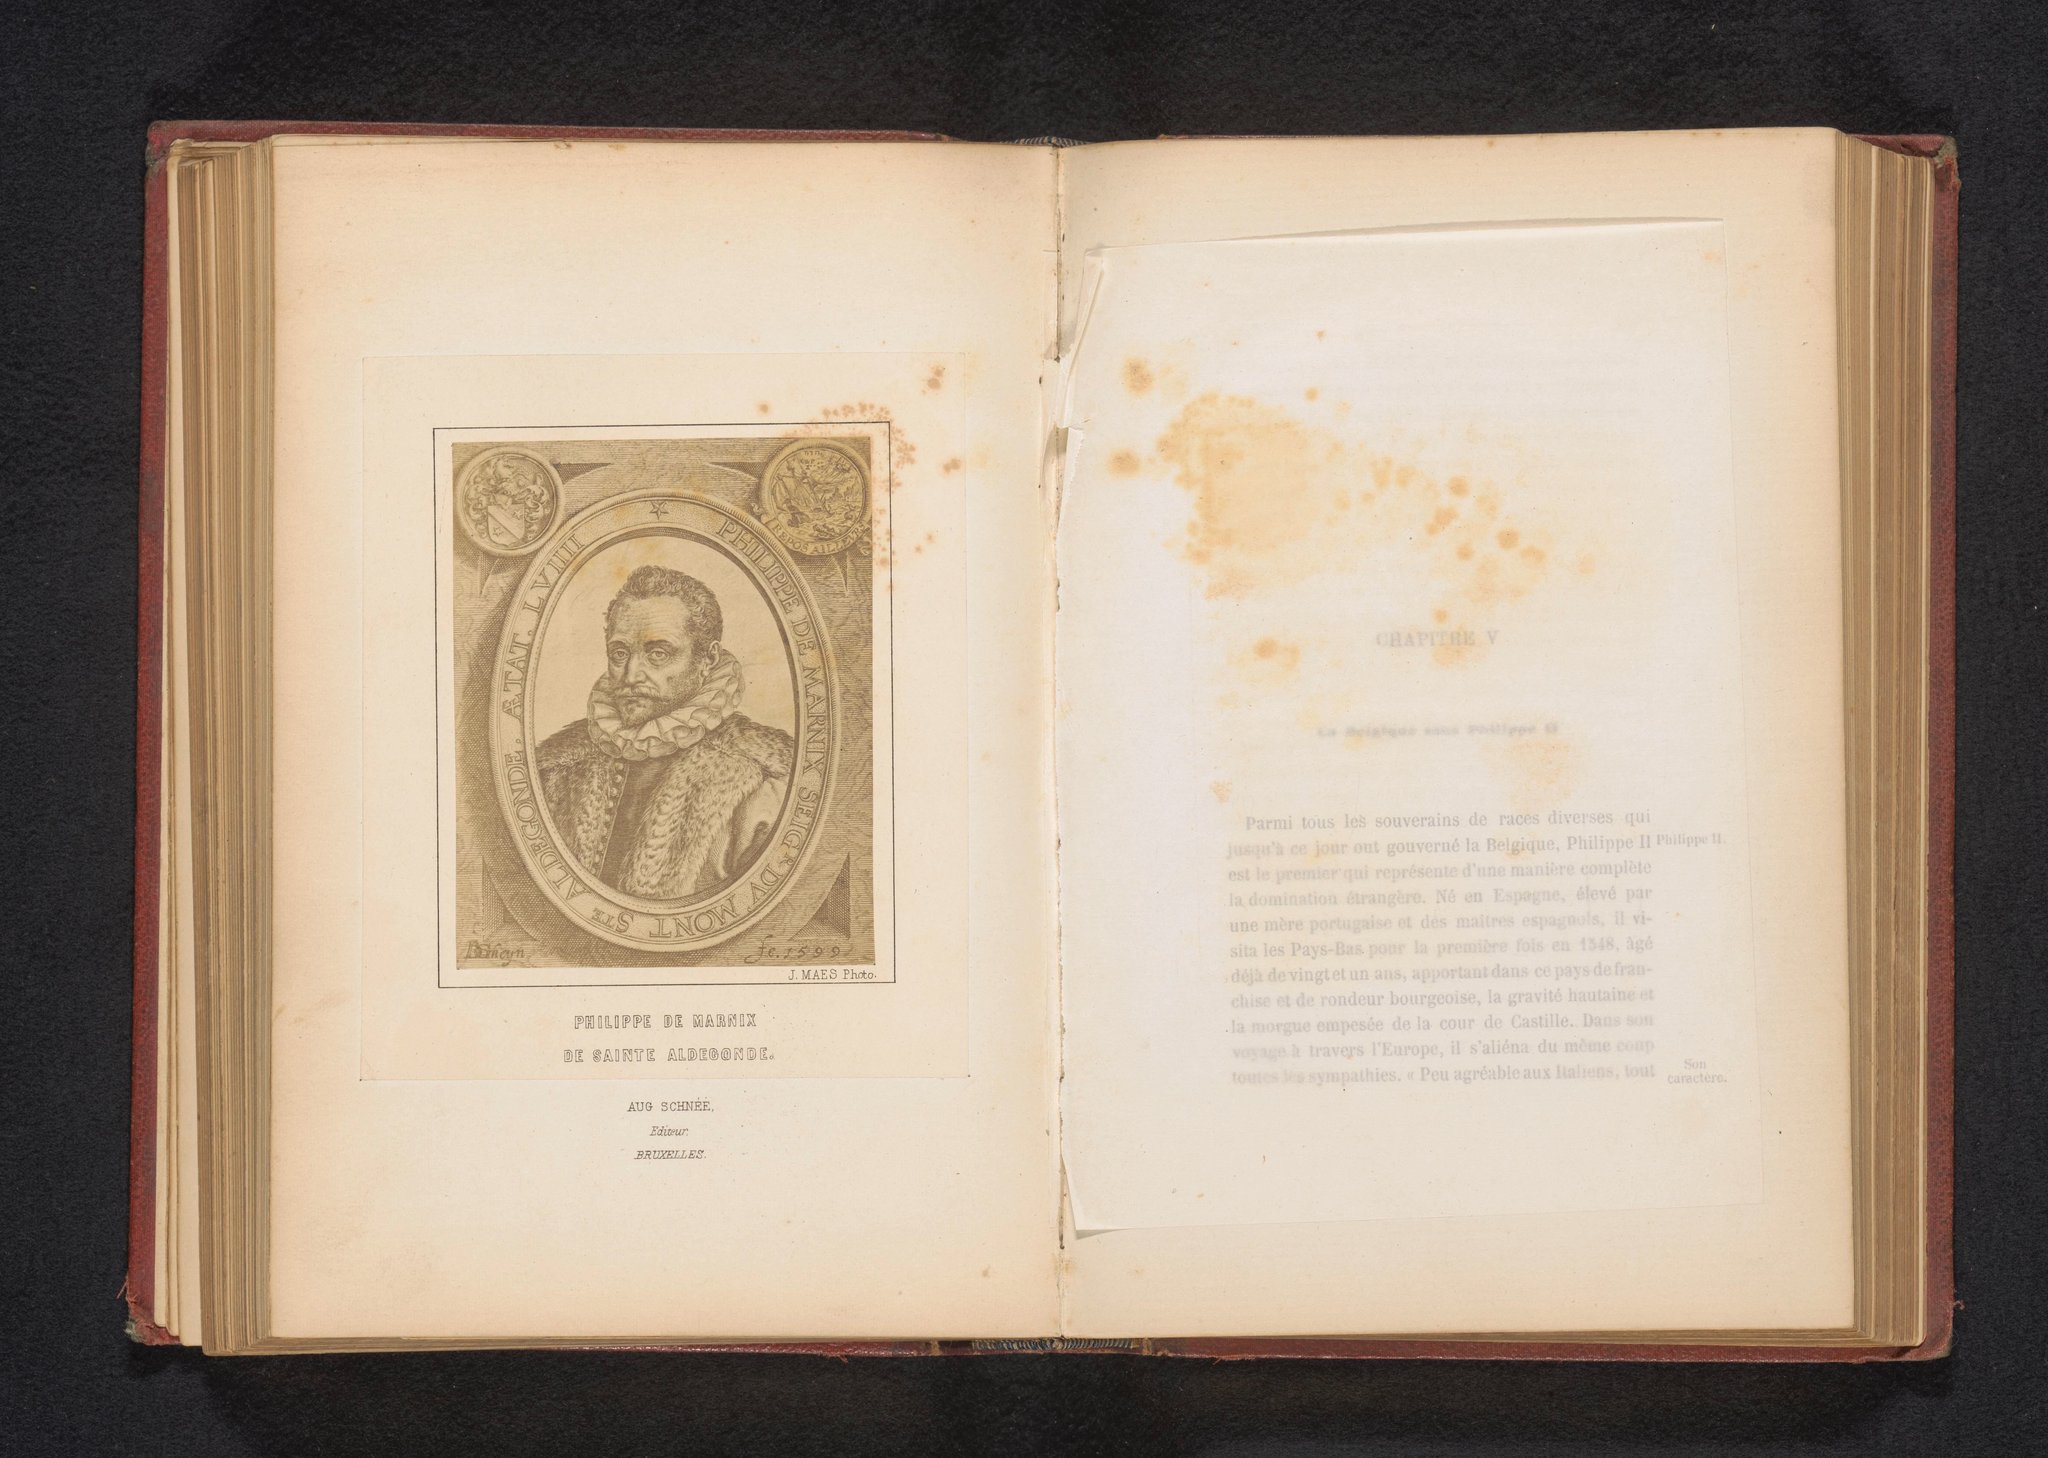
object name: photograph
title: Fotoreproductie van een portret van Filips van Marnix van Sint-Aldegonde door Jacob de Gheyn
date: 1855-1860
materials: photographic support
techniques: albumen print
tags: brussels, leiden, politician, filips van marnix van sint-aldegonde, historical persons